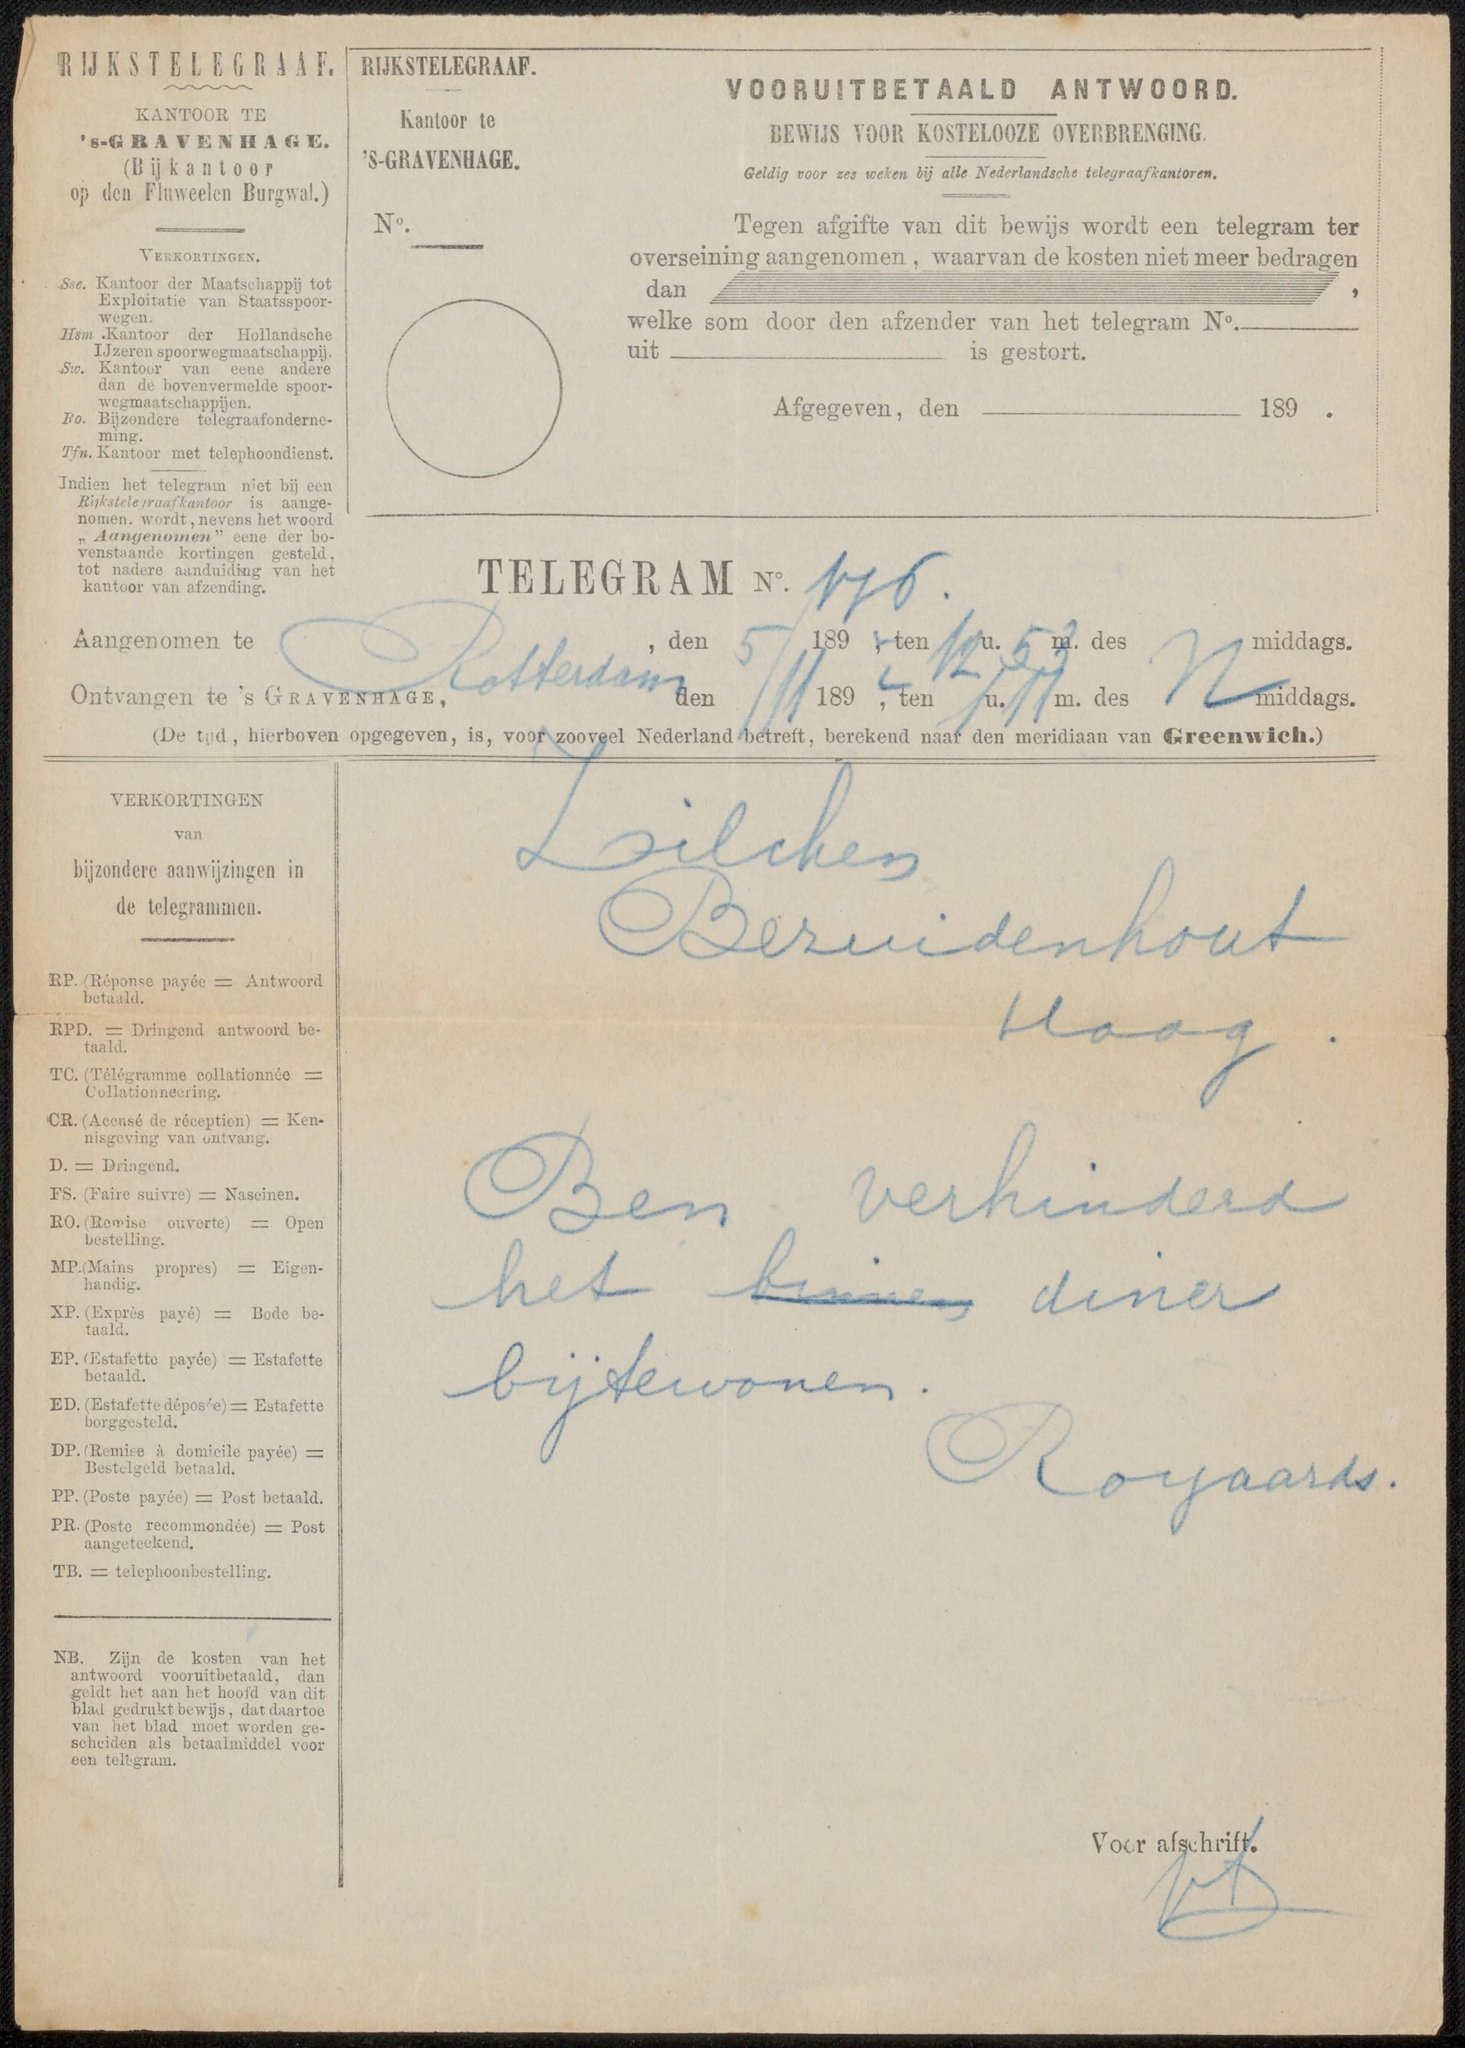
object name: telegram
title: Telegram aan Philip Zilcken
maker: willem cornelis royaards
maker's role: acteur, regisseur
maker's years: 1867-1929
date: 1892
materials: ink, paper, pencil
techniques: printing, writing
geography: rotterdam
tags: paris, paul verlaine, the hague, painter, draughtsman, philip zilcken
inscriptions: collector's mark: ‘RPK’